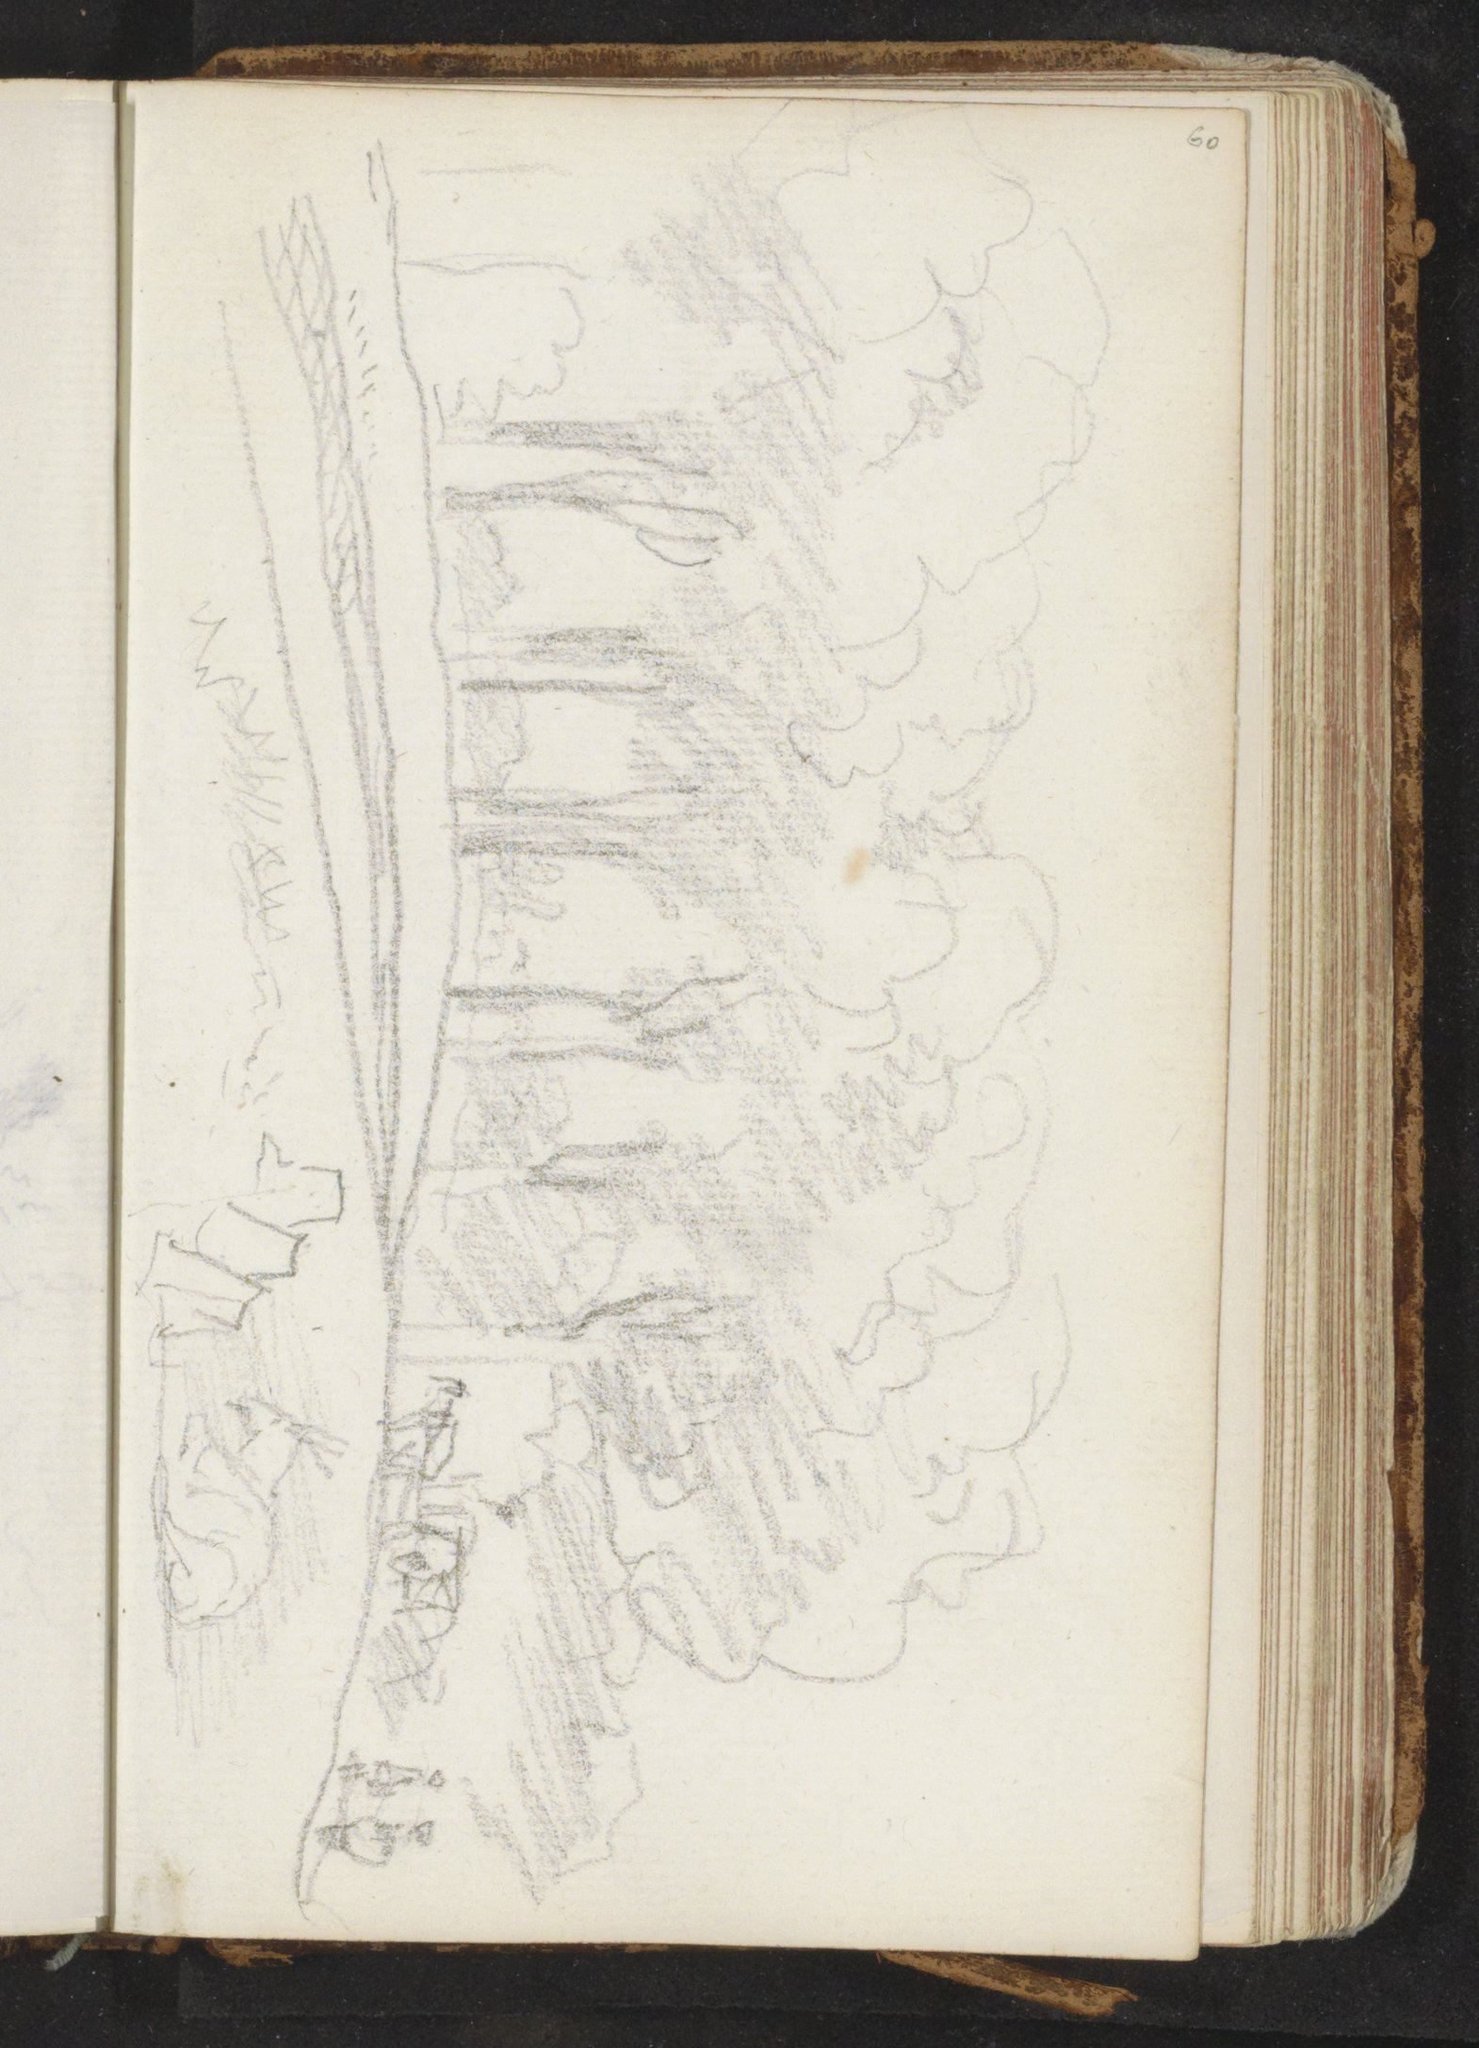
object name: sketchbook leaf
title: Paard en wagen op een bomenlaan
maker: jean honoré fragonard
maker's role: draughtsman, painter, print maker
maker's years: 1732-1806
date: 1765-1775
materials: paper, pencil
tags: animal traction, animal-drawn vehicle (carriage etc.), forest path or lane (+ landscape with figures, staffage)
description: Op de laan lopen ook figuren. Op de voorgrond ligt een geit op het gras. Blad 60 recto uit een schetsboek met 83 bladen.